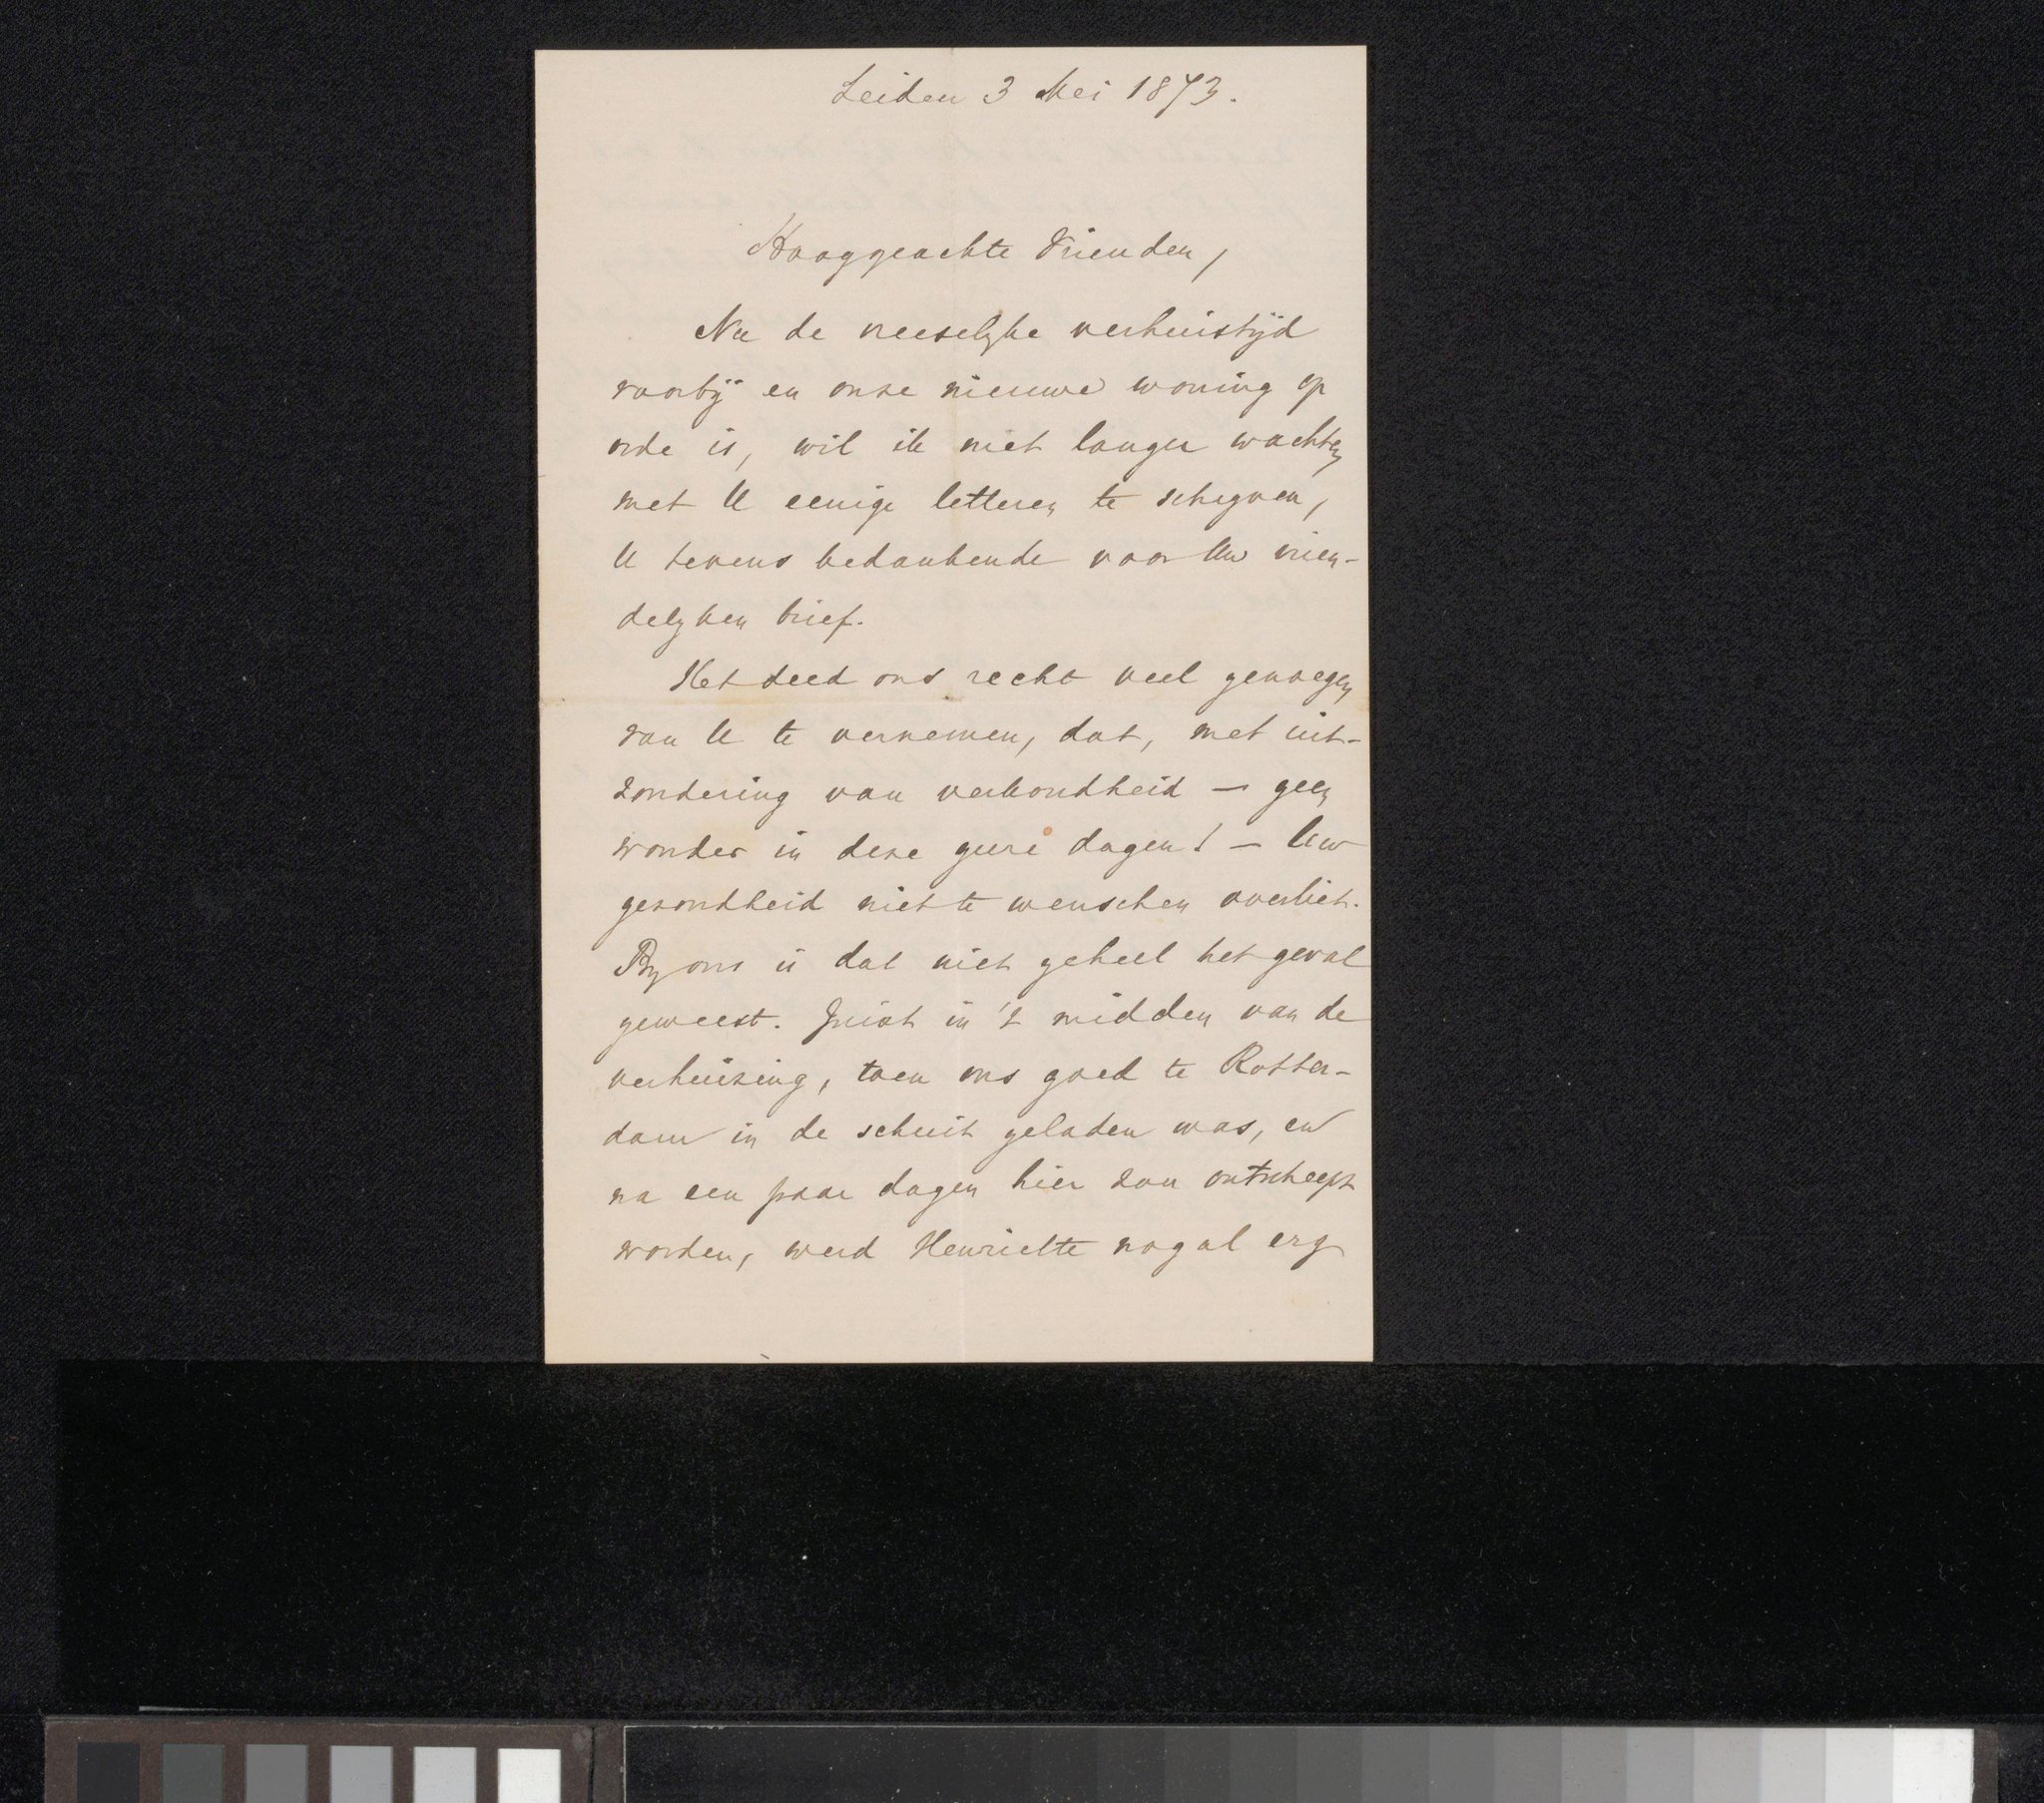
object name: letter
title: Brief aan Ary Johannes Lamme en Adriana Lamme-van Geller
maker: cornelis petrus tiele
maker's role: theoloog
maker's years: 1830-1902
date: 1873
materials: ink, paper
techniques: pen, writing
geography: leiden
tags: rotterdam, painter, draughtsman, adriana lamme-van geller, ary johannes lamme, family life, diseases, leiden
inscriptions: collector's mark: Lugt 2228